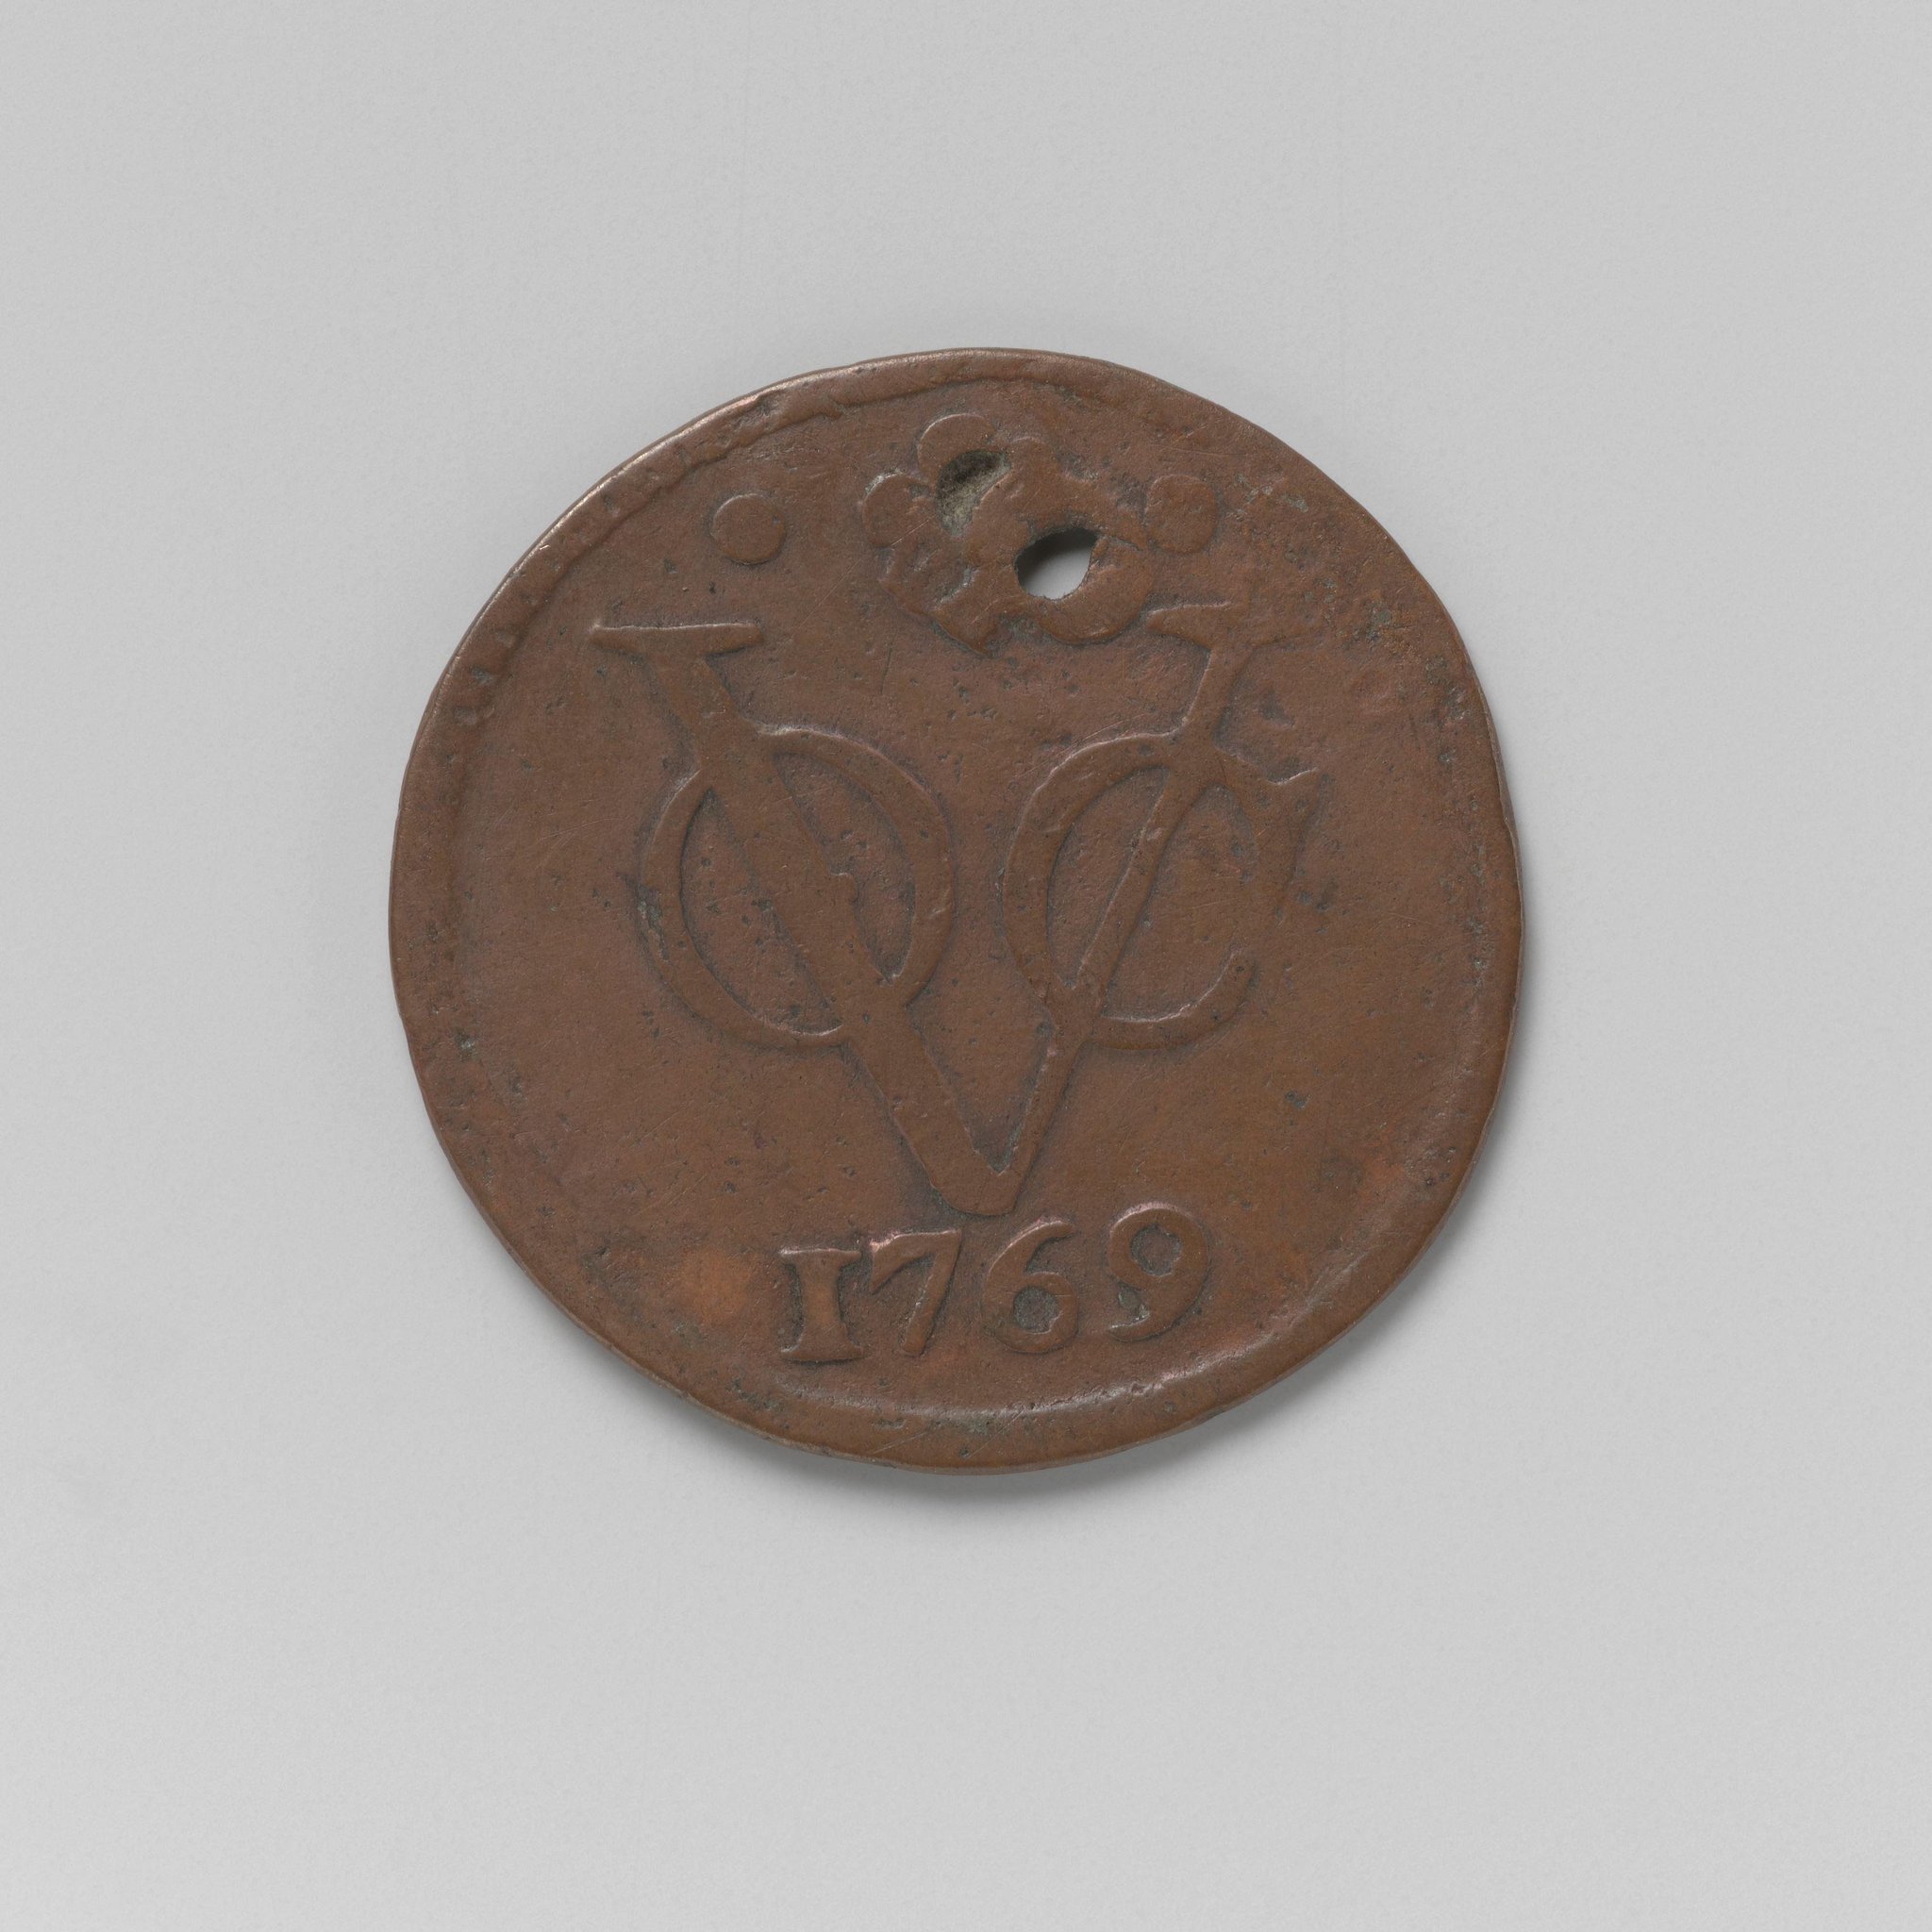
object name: coin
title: ½ duit van de VOC uit Holland, 1769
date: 1769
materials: copper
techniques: striking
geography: dordrecht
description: Koperen munt. Voorzijde: gekroond wapenschild van Holland. Keerzijde: monogram van de VOC, waarboven muntteken en waaronder jaartal. Gladde rand. Muntplaatje doorboord.